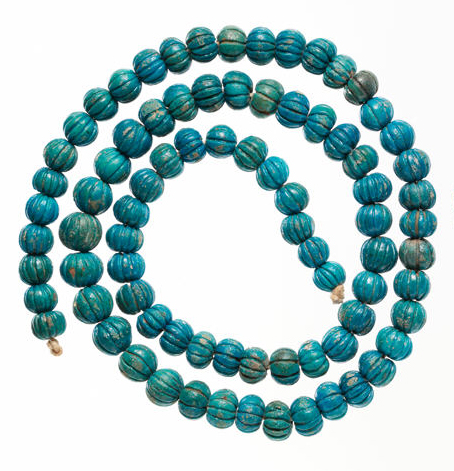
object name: necklace, bead, melon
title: Melon Bead Necklace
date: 1550-1425 BCE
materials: faience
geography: egypt